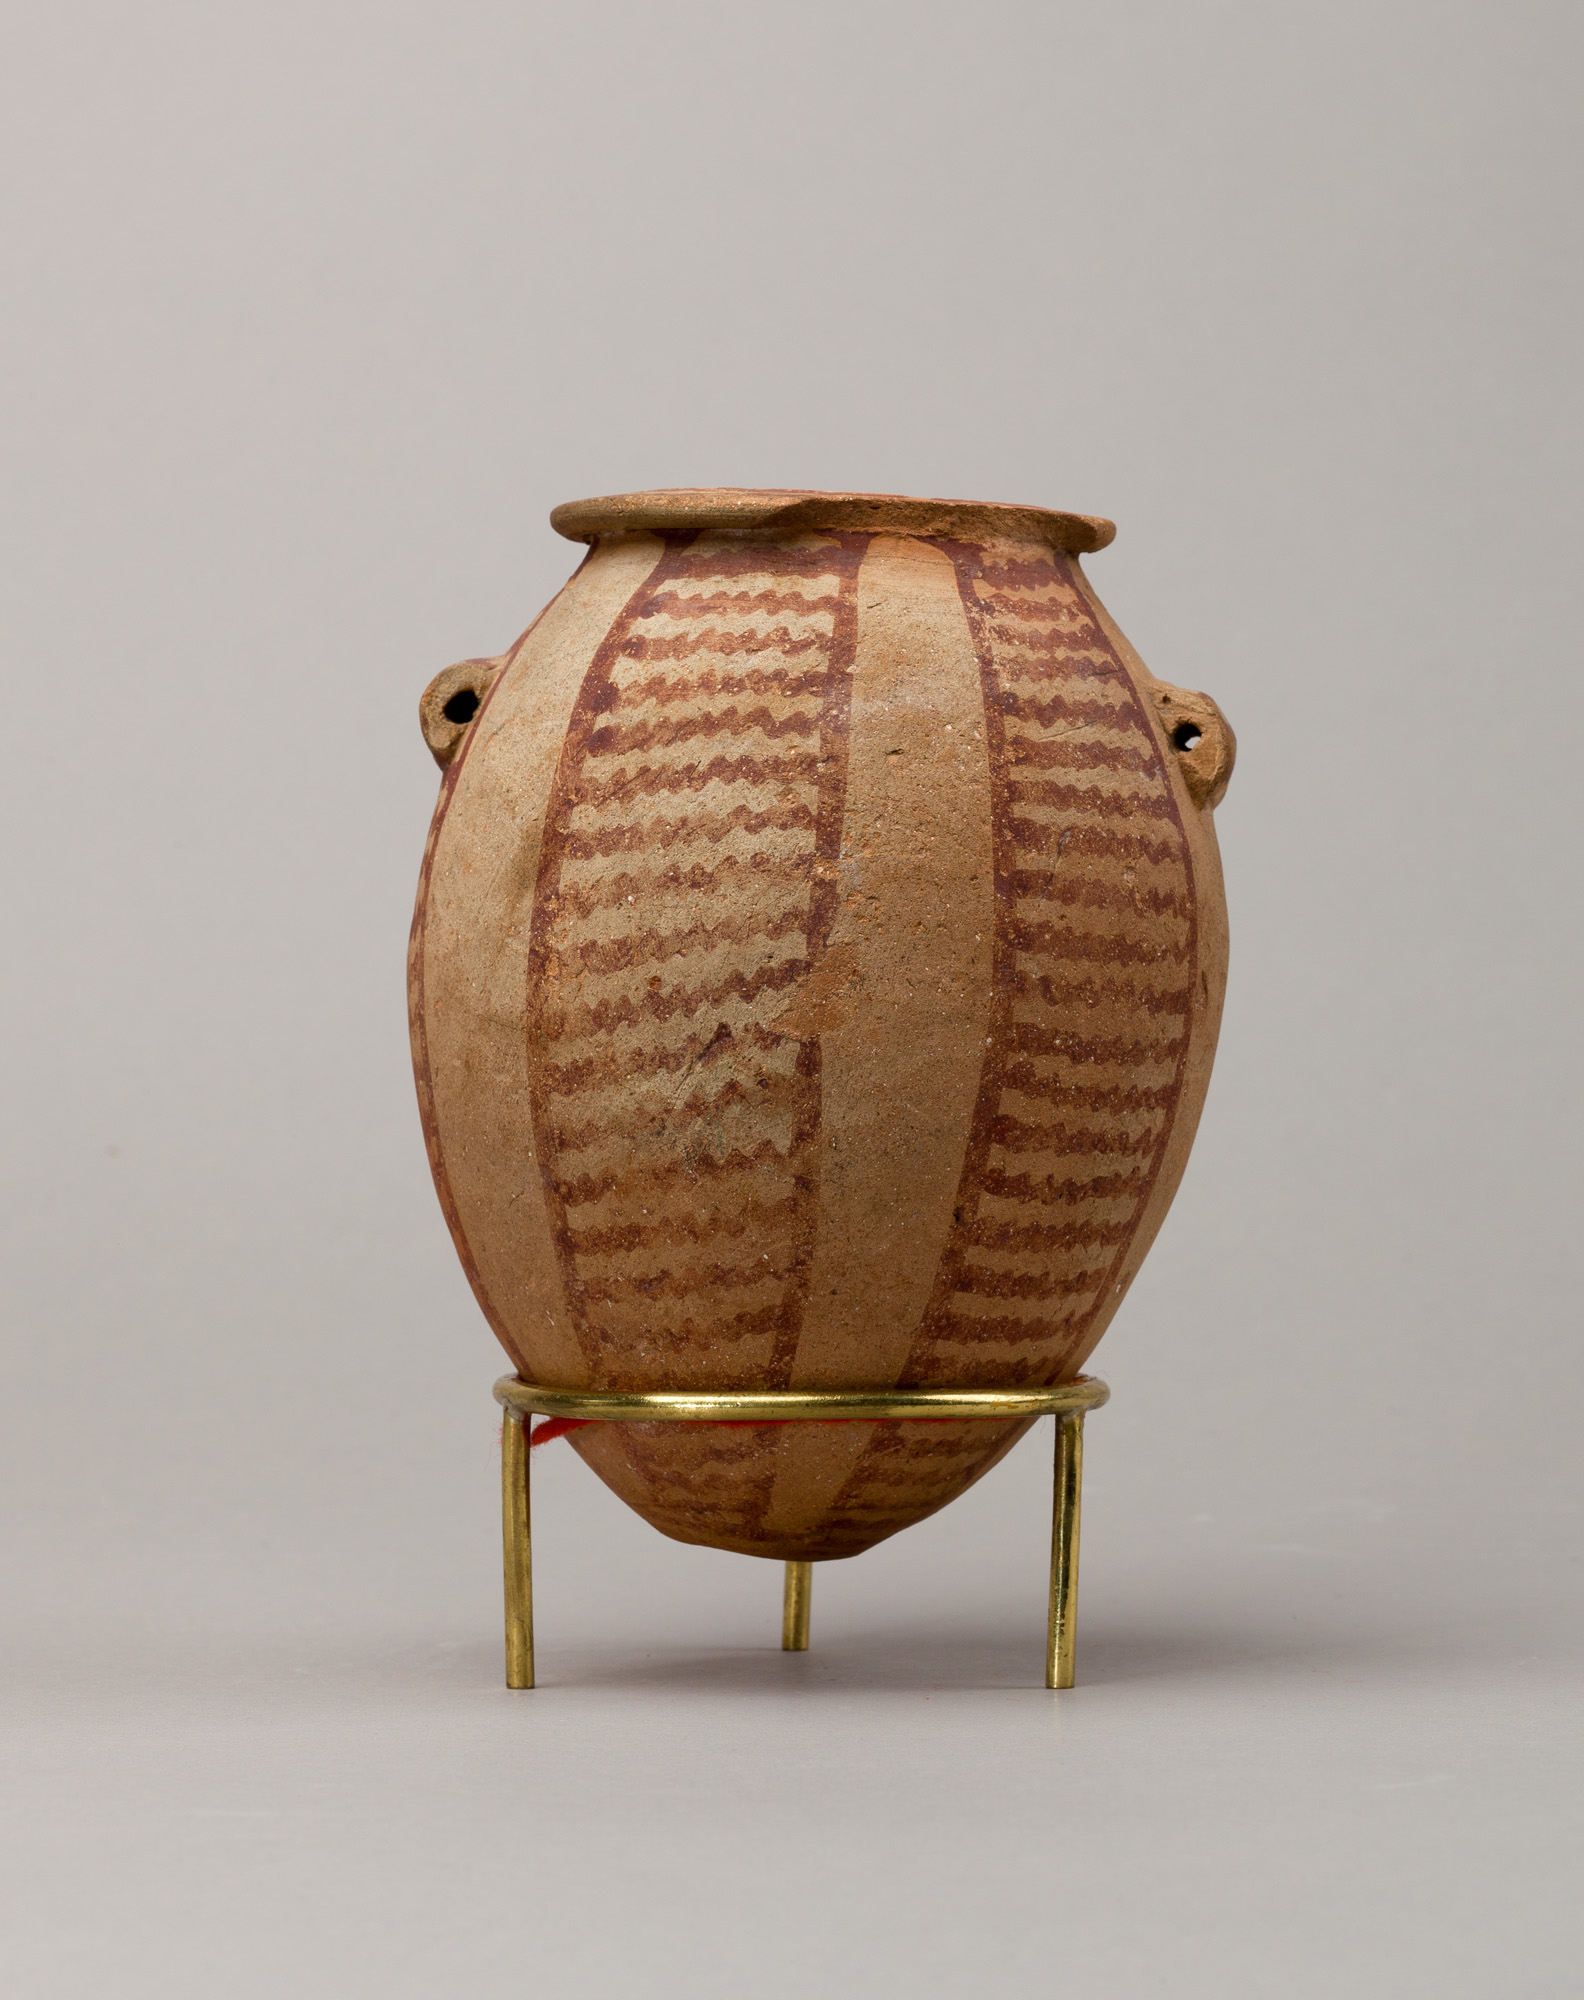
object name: jar, decorated ware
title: Decorated ware jar with lug handles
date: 3850-2960 BCE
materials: paint, pottery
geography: egypt